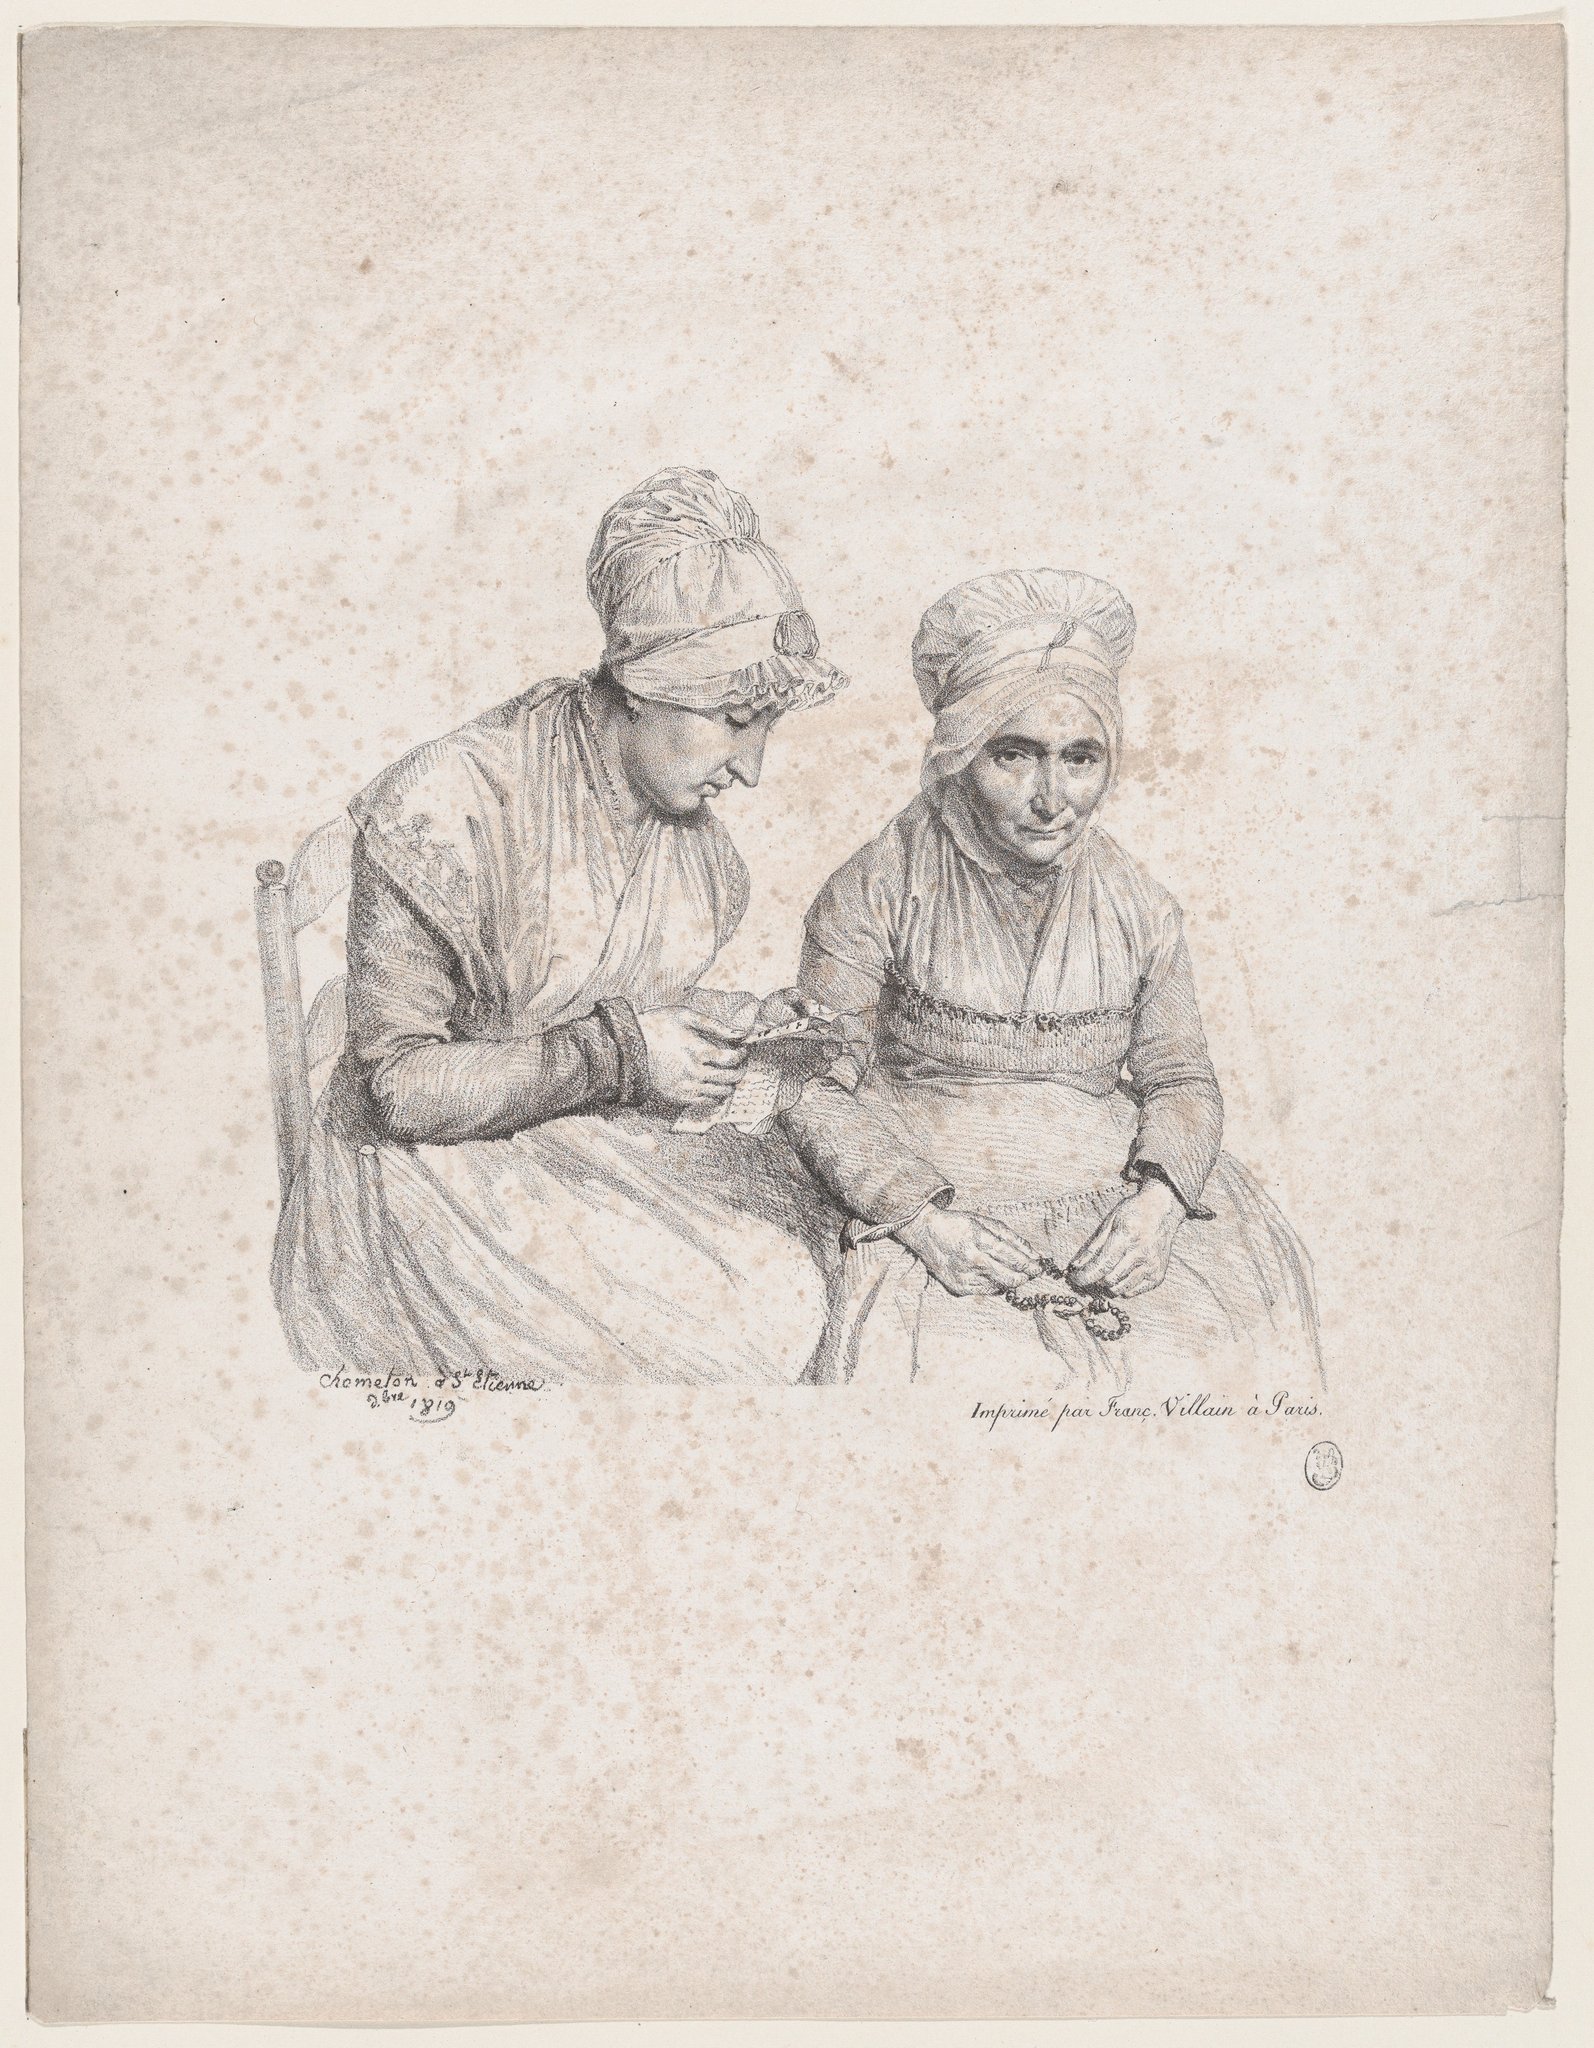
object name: print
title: The Letter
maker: jean-baptiste chometon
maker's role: artist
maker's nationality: french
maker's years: 1789-1832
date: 1819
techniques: lithograph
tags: women,reading